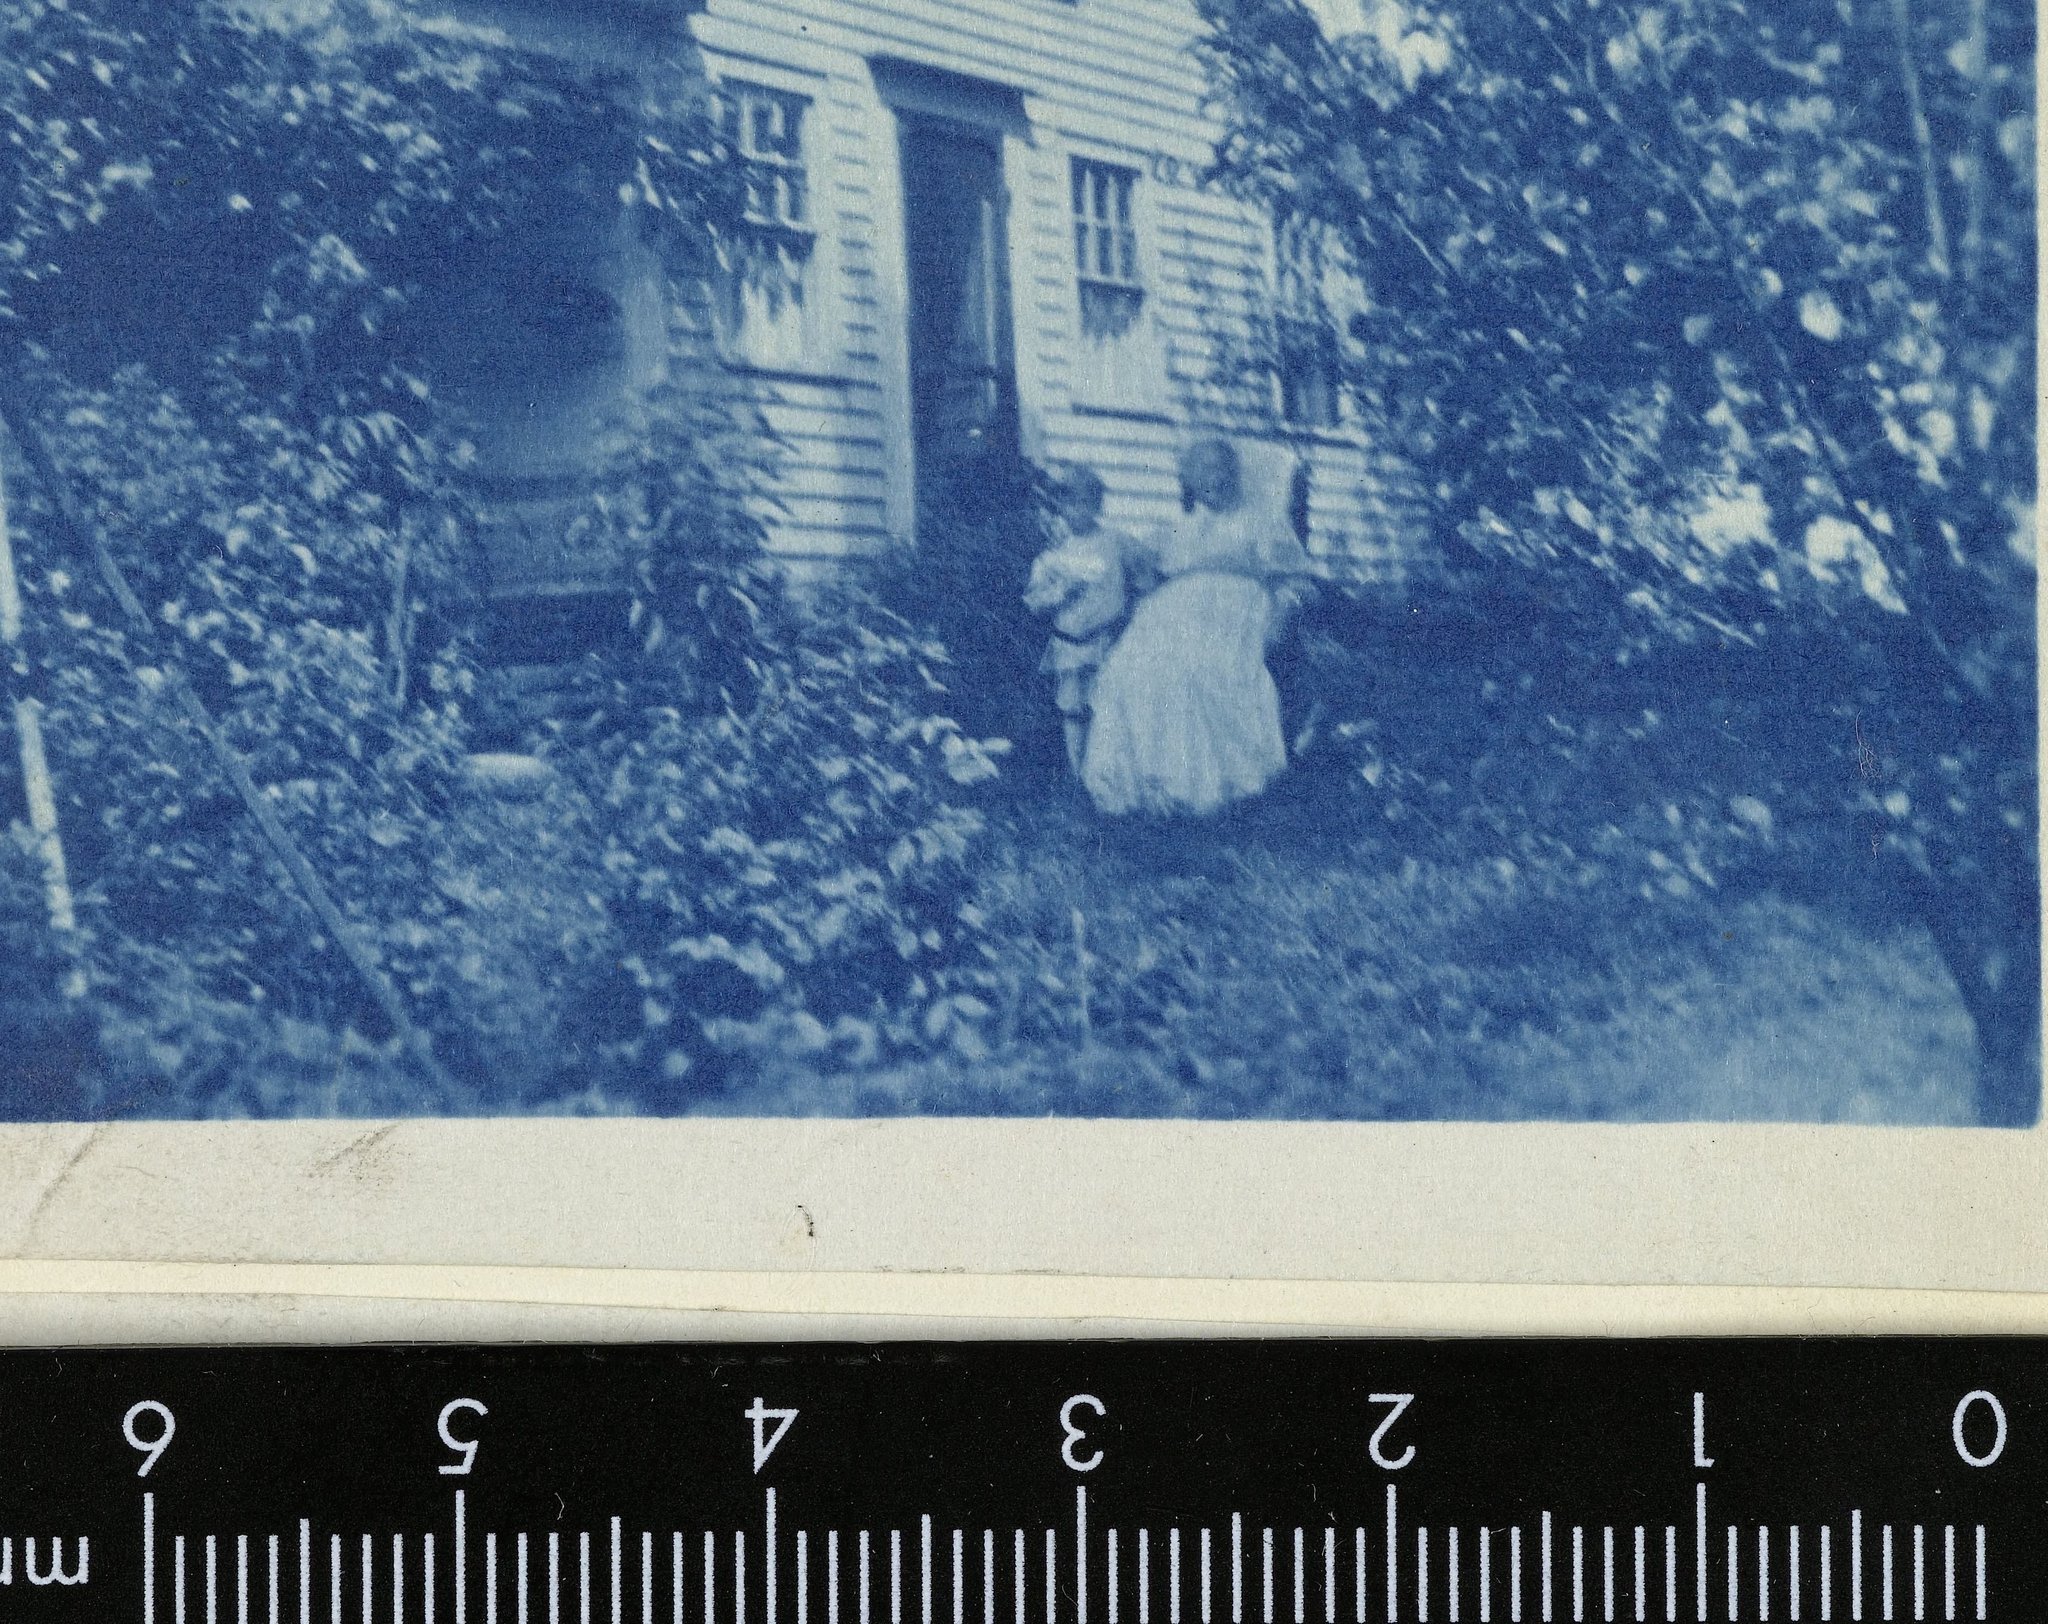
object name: photograph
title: Vrouw en kind voor een huis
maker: Anonymous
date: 1890-1910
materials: paper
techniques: cyanotype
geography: north and central america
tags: country-house